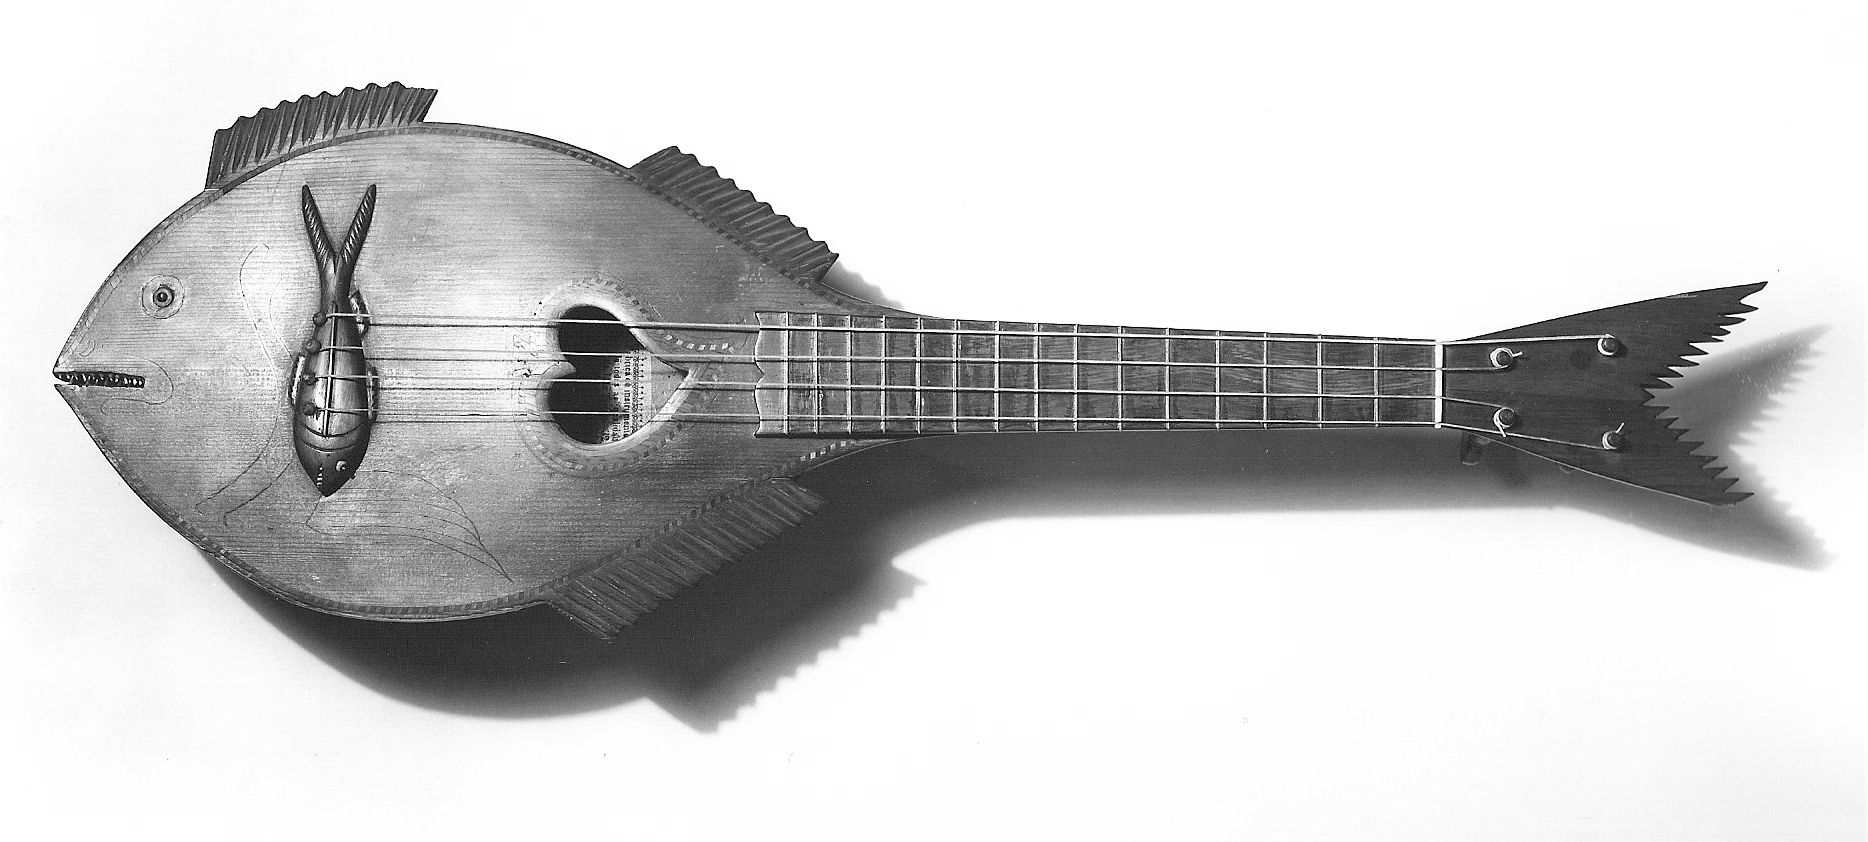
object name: rajão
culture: portuguese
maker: augusto merciano da costa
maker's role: maker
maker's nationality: portuguese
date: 1867-1900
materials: wood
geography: portugal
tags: fish